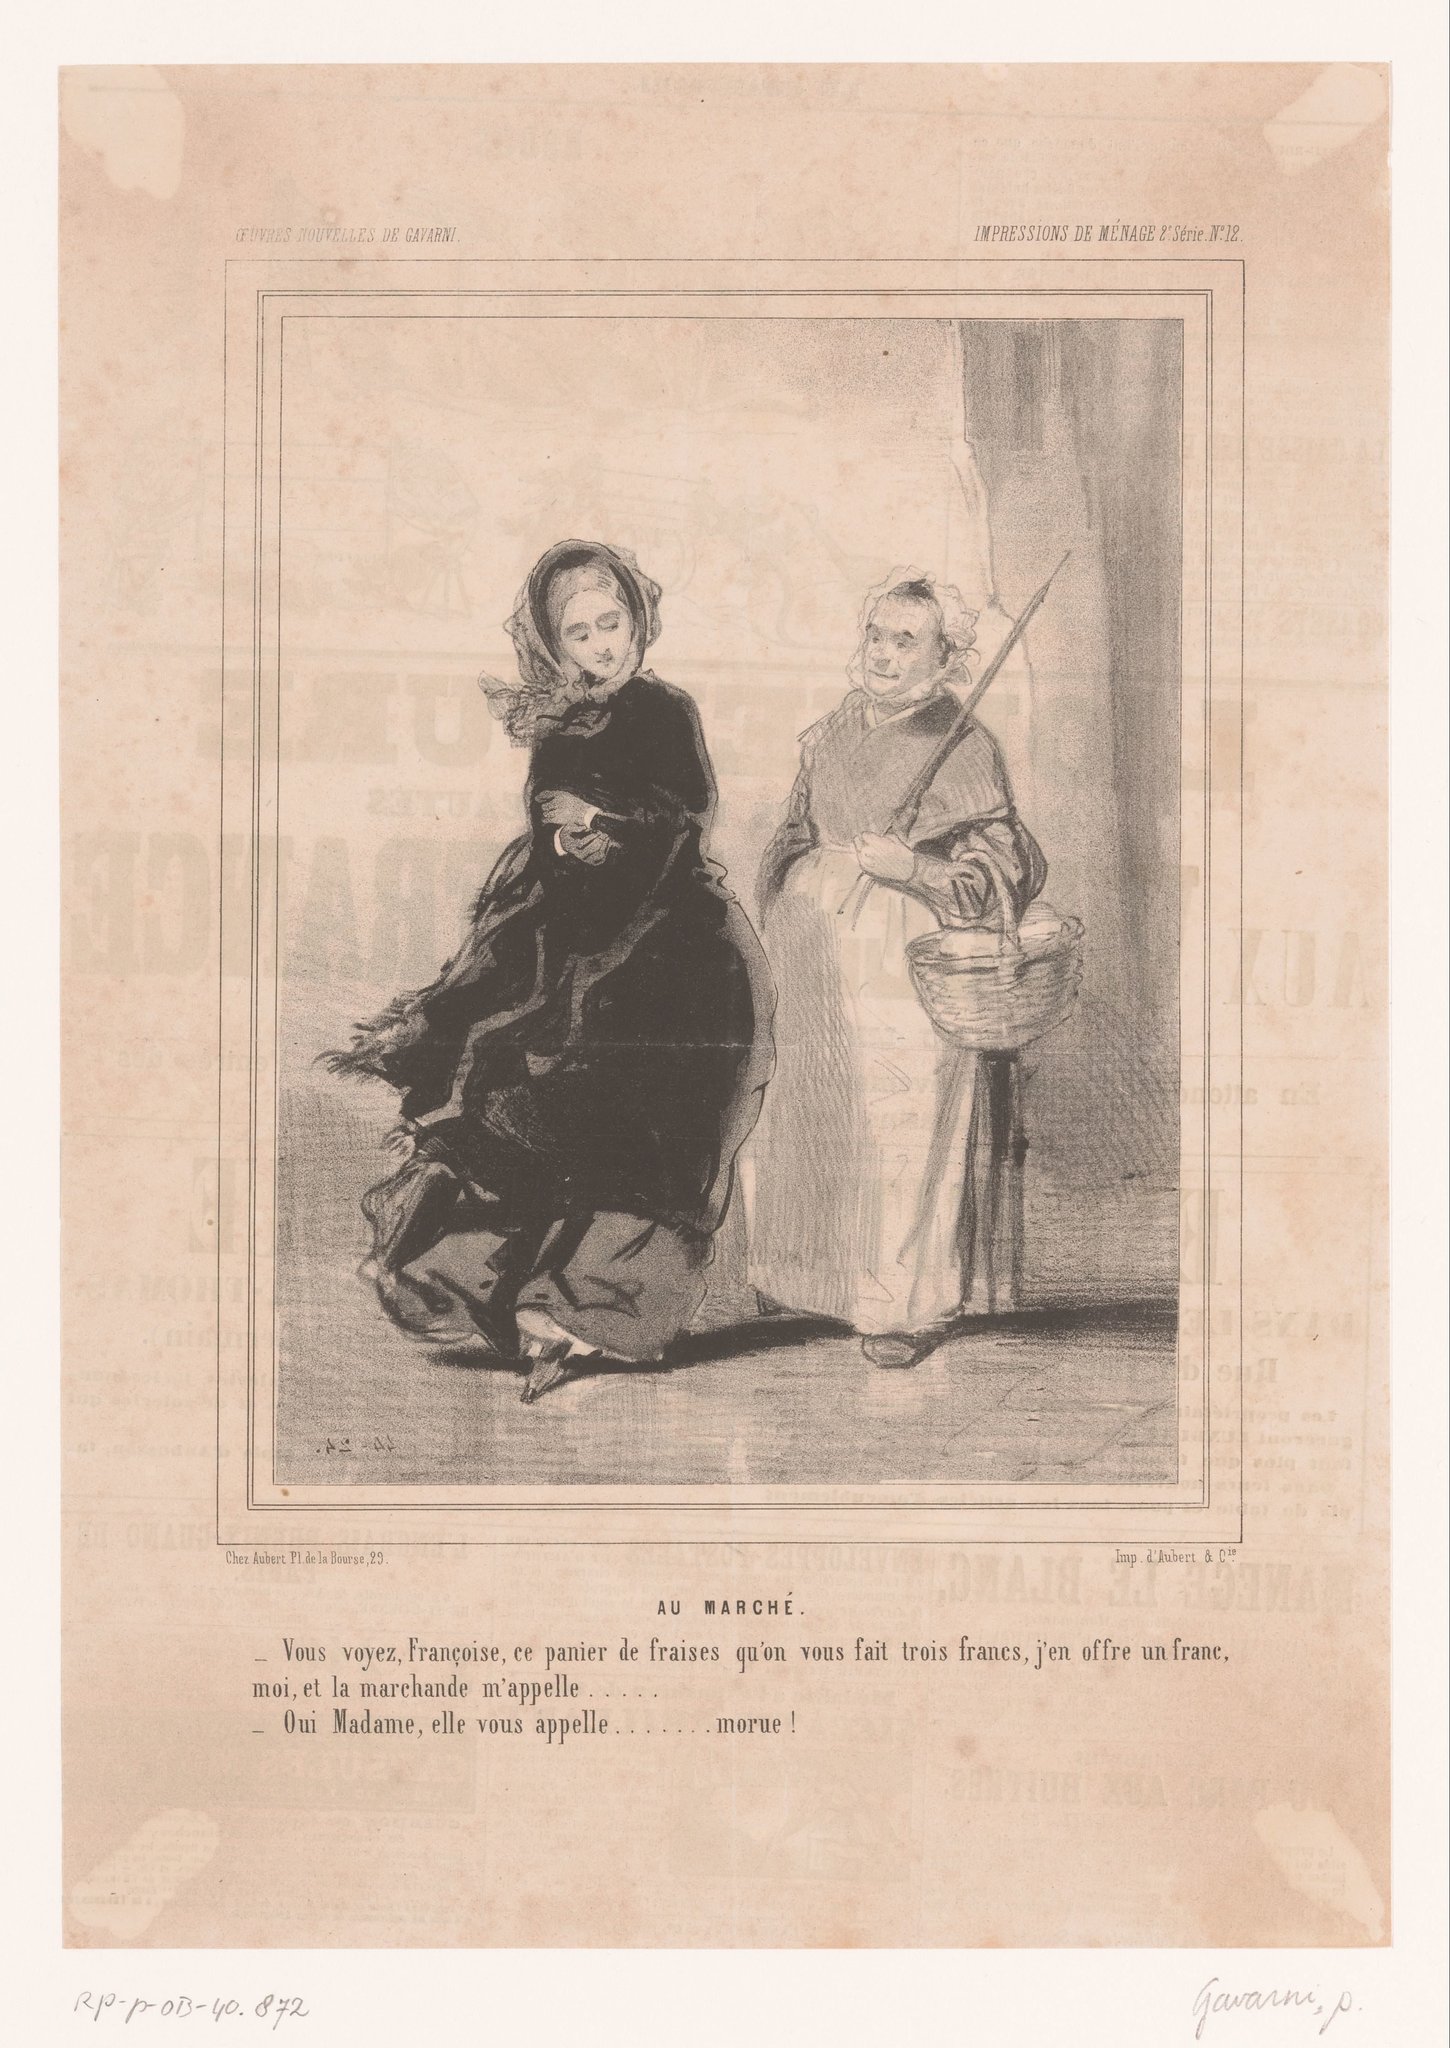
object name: cartoon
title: Jonge vrouw met oude keukenmeid op de markt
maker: paul gavarni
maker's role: draughtsman, print maker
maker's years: 1804-1866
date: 1846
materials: paper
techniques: lithograph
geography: paris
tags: market, kitchen-maid, kitchen servant, marketing, shopping (~ household management)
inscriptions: collector's mark: Lugt 2228a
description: Prent gebruikt voor: Le Charivari, 11 oktober 1846.